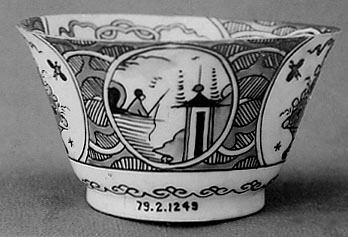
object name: cup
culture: japanese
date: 1701-1800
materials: enamel, porcelain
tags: human figures